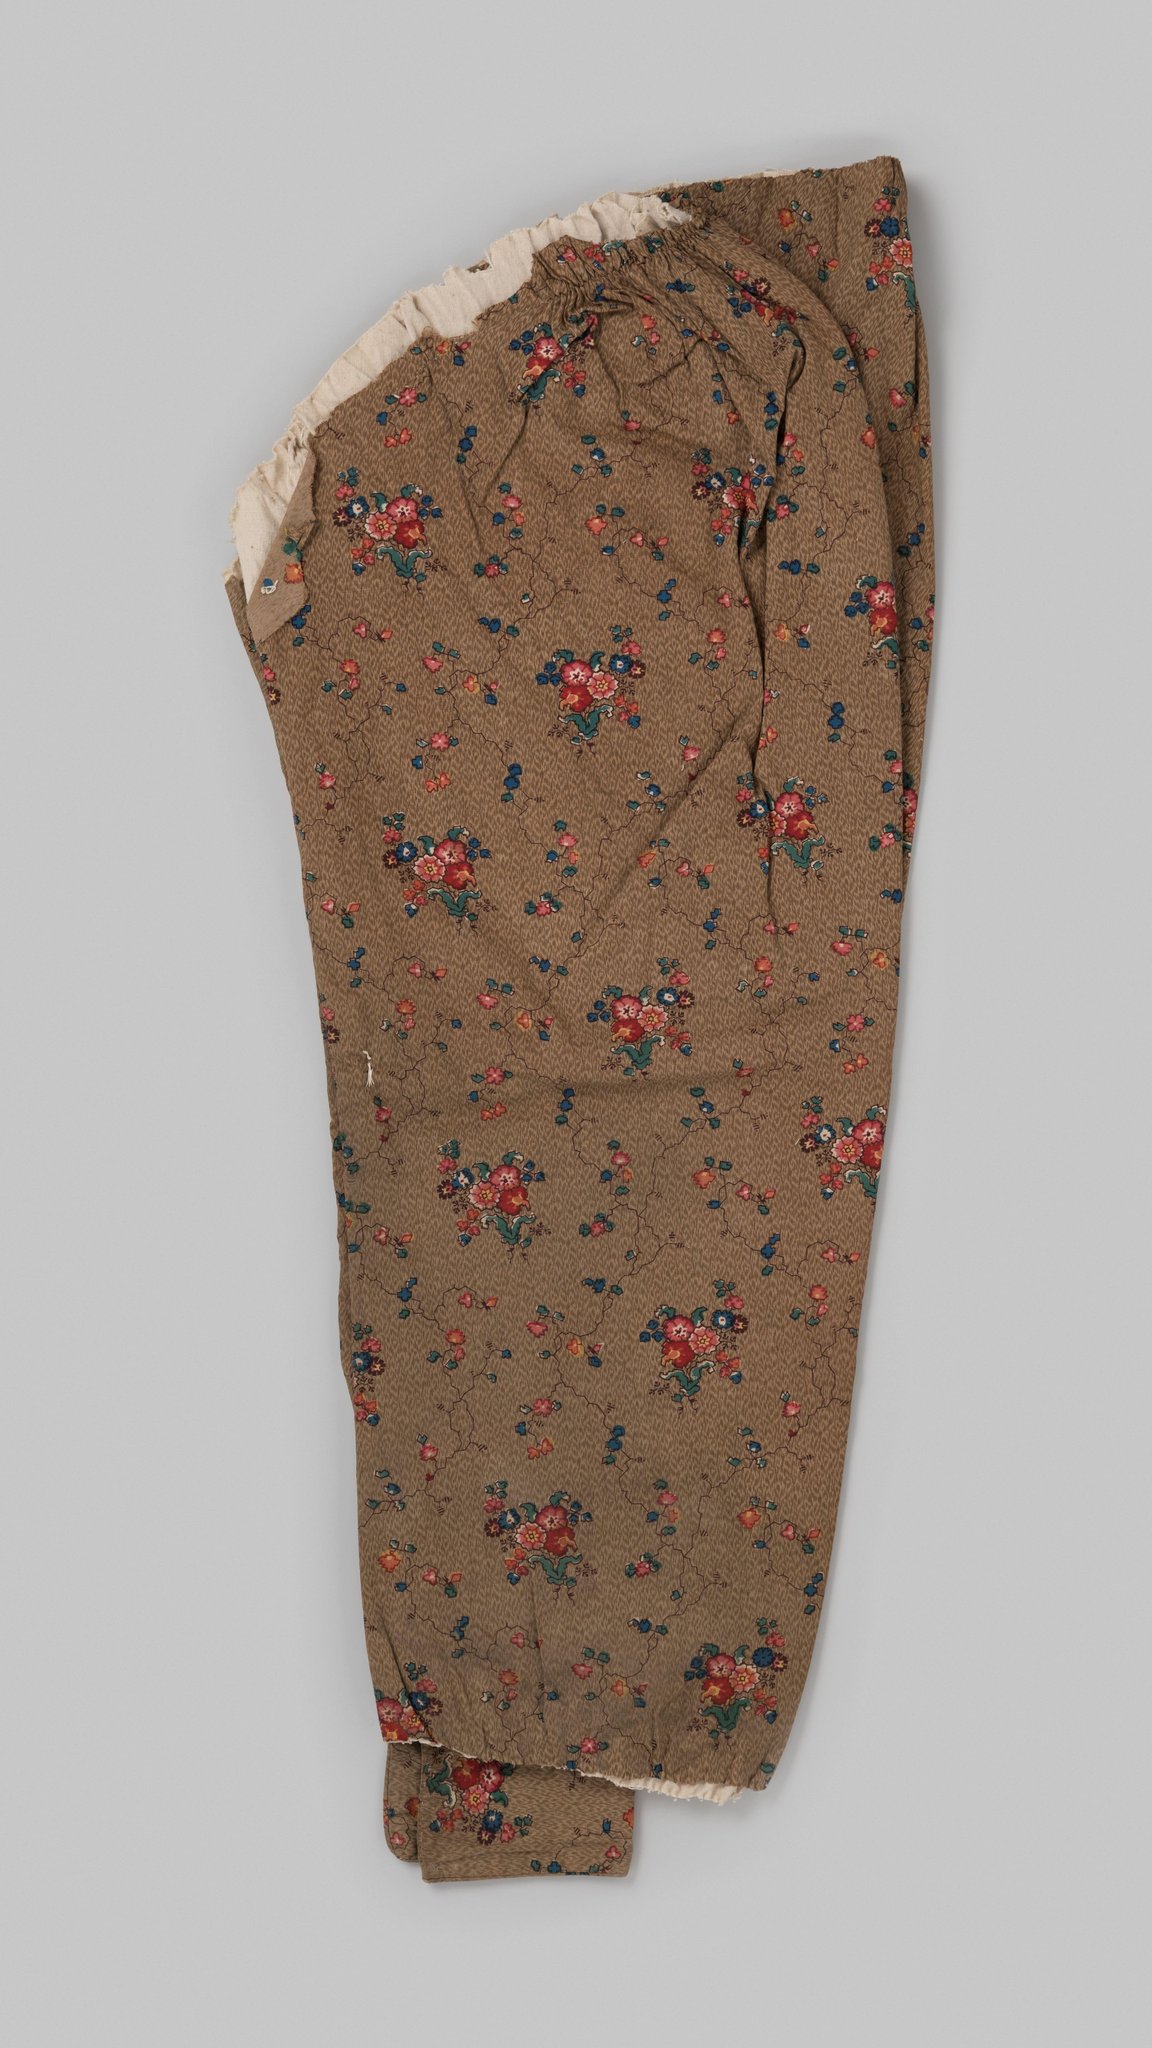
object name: womenswear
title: Mouw van bedrukte katoen, gekleurde bloemen op een bruin gemeleerd fond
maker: Anonymous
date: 1700-1800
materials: cotton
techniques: printing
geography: netherlands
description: Mouw, gevoerd, van bedrukte katoen. Het patroon bestaat uit gekleurde bloemen en een slingermotief op een bruin gemeleerd fond. De mouw is afkomstig van een damesjak. De manchet is afgeknipt en ontbreekt.